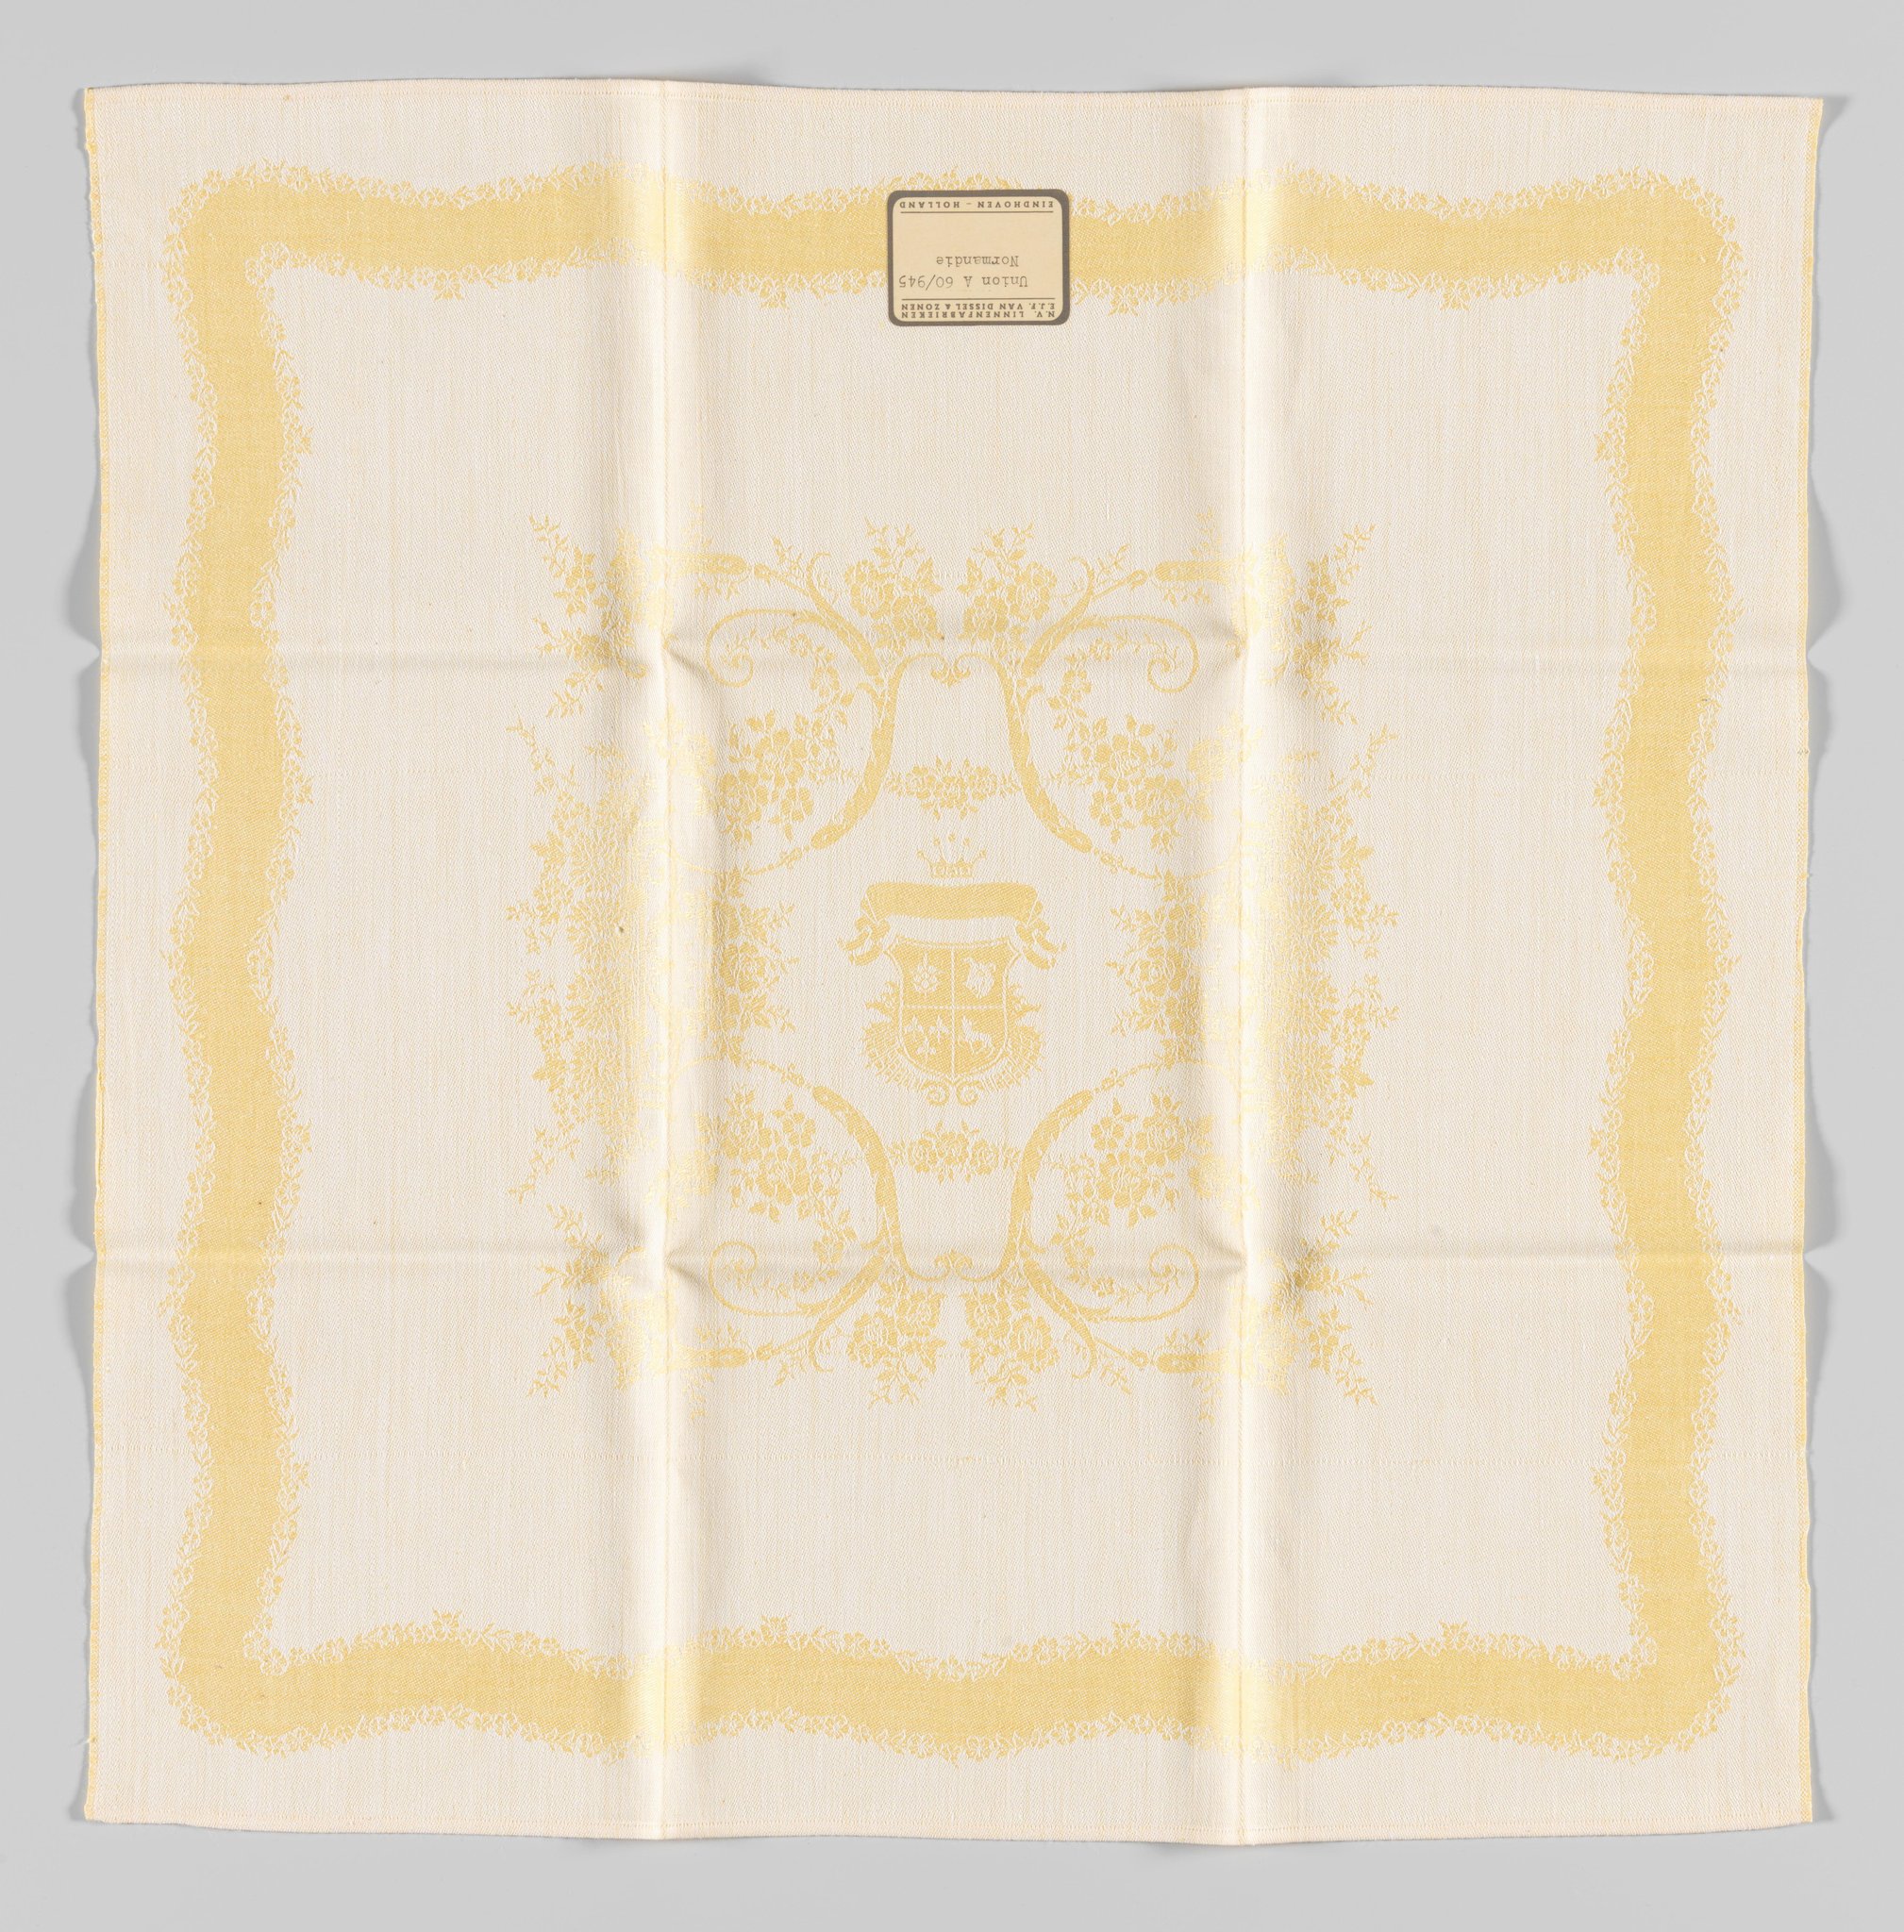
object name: napkin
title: Servet van katoenen damast met wapen Hotel Normandie (?)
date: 1871-1971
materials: cotton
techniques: damask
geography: eindhoven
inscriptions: label: ‘N.V. Linnenfabrieken E.J.F. van Dissel & zonen, Eindhoven, Holland 'Union A 60/945 Normandie"’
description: Servet van gele katoenen damast met het wapen van Hotel Normandie (?). Inslag geel, ketting wit.